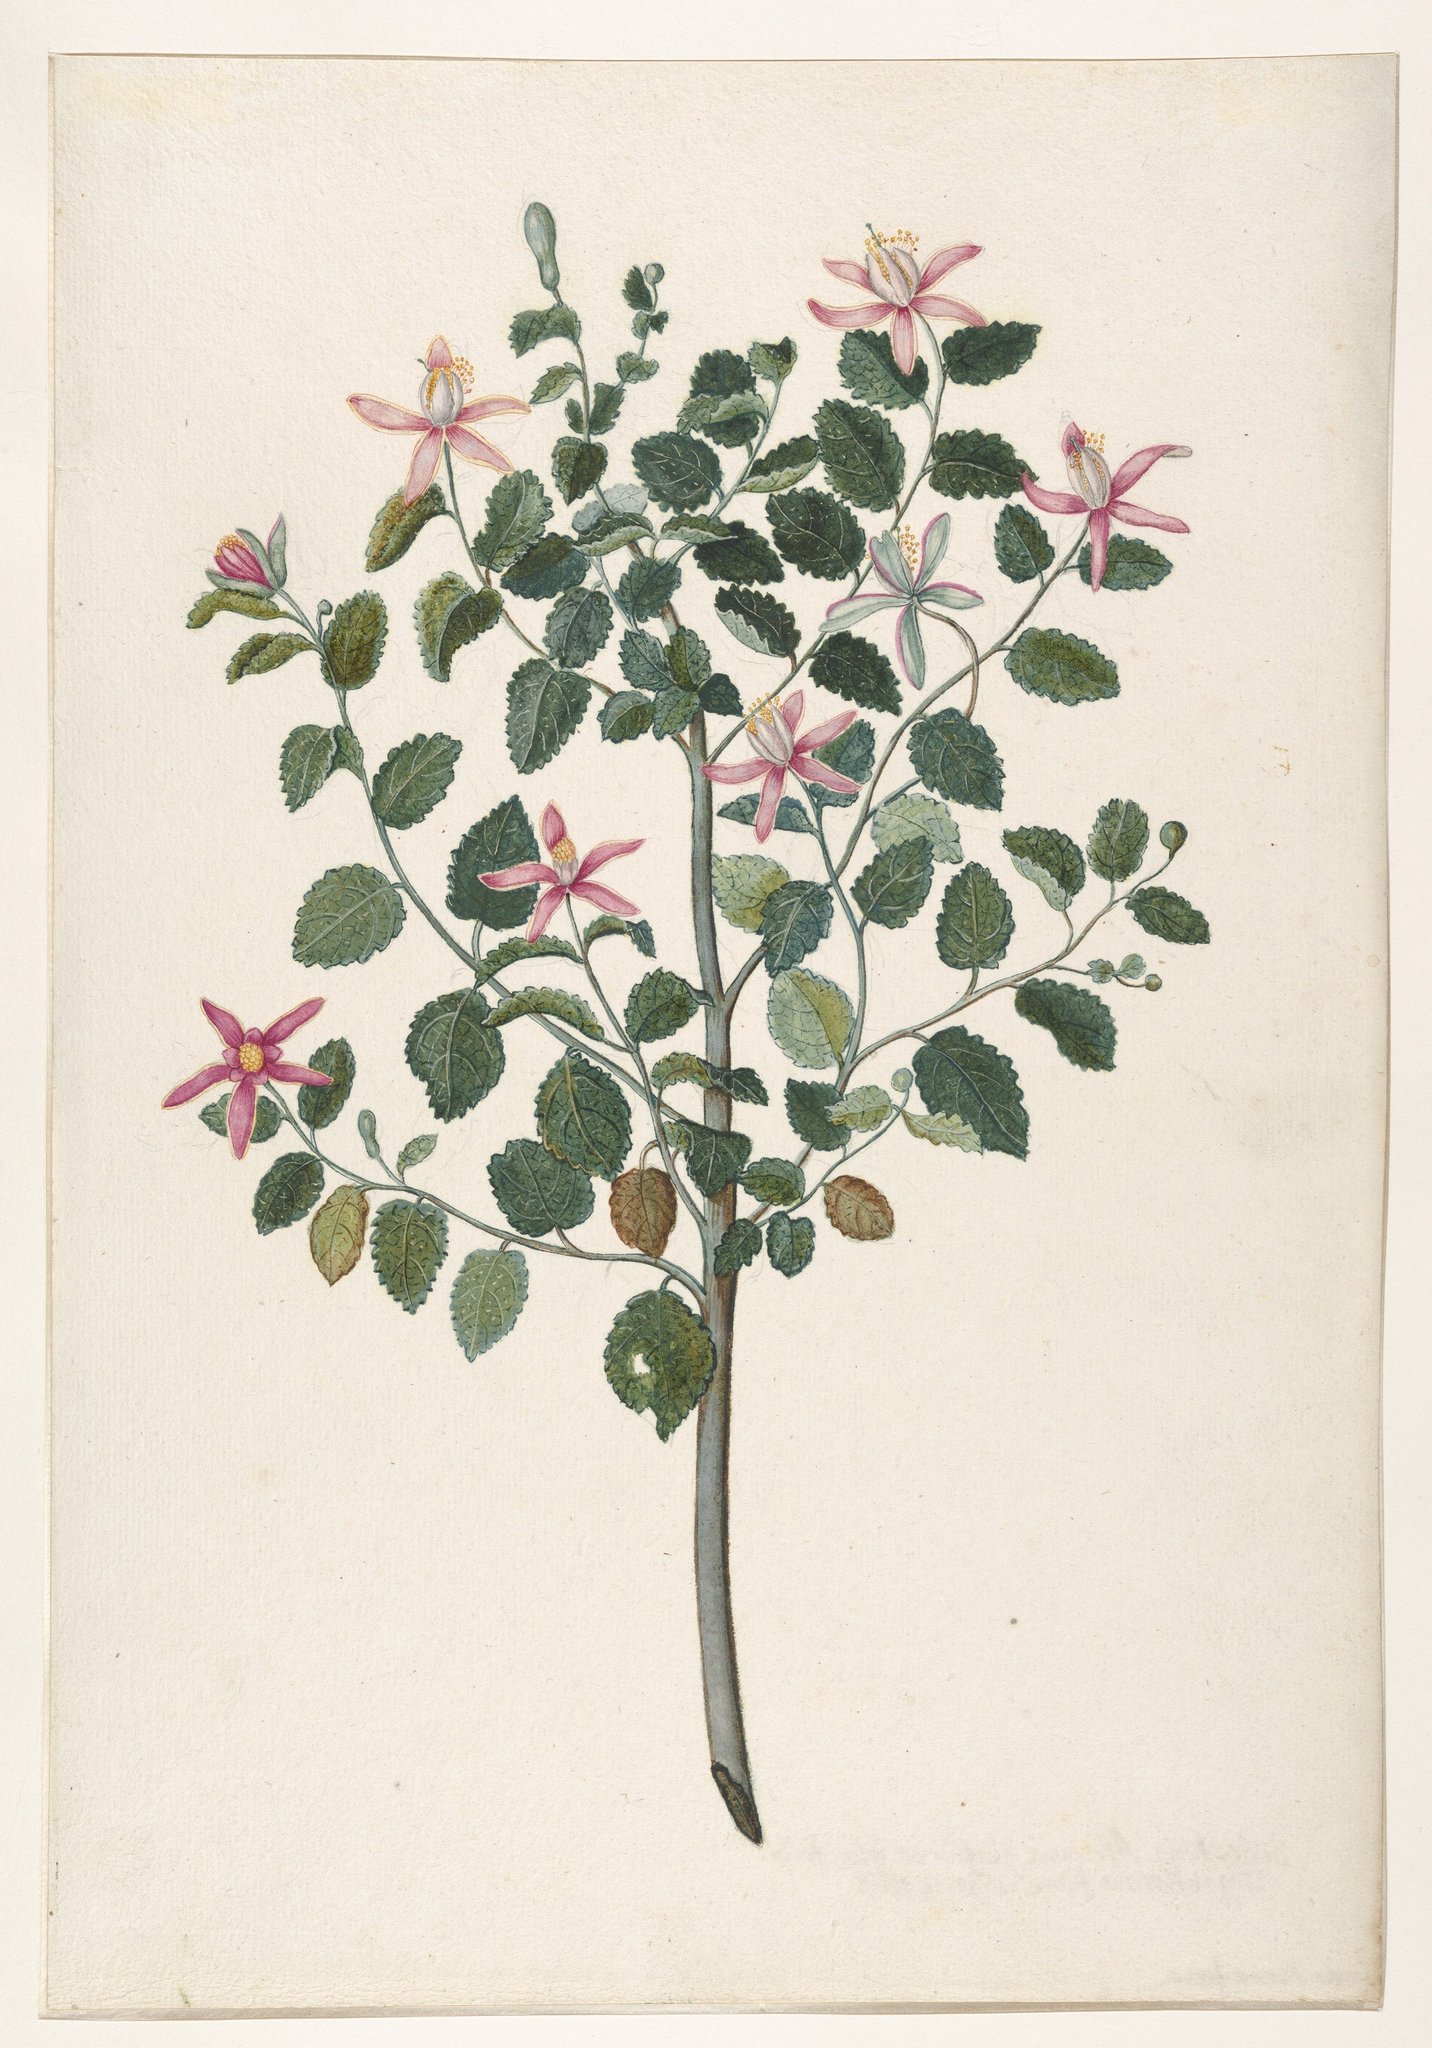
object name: drawing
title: Study of a Plant with Red-Purple Flowers (Sebastiana africana purpurea)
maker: maria moninckx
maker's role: artist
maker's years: 1673-1757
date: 1695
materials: gouache, graphite, watercolor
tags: flowers,plants,leaves